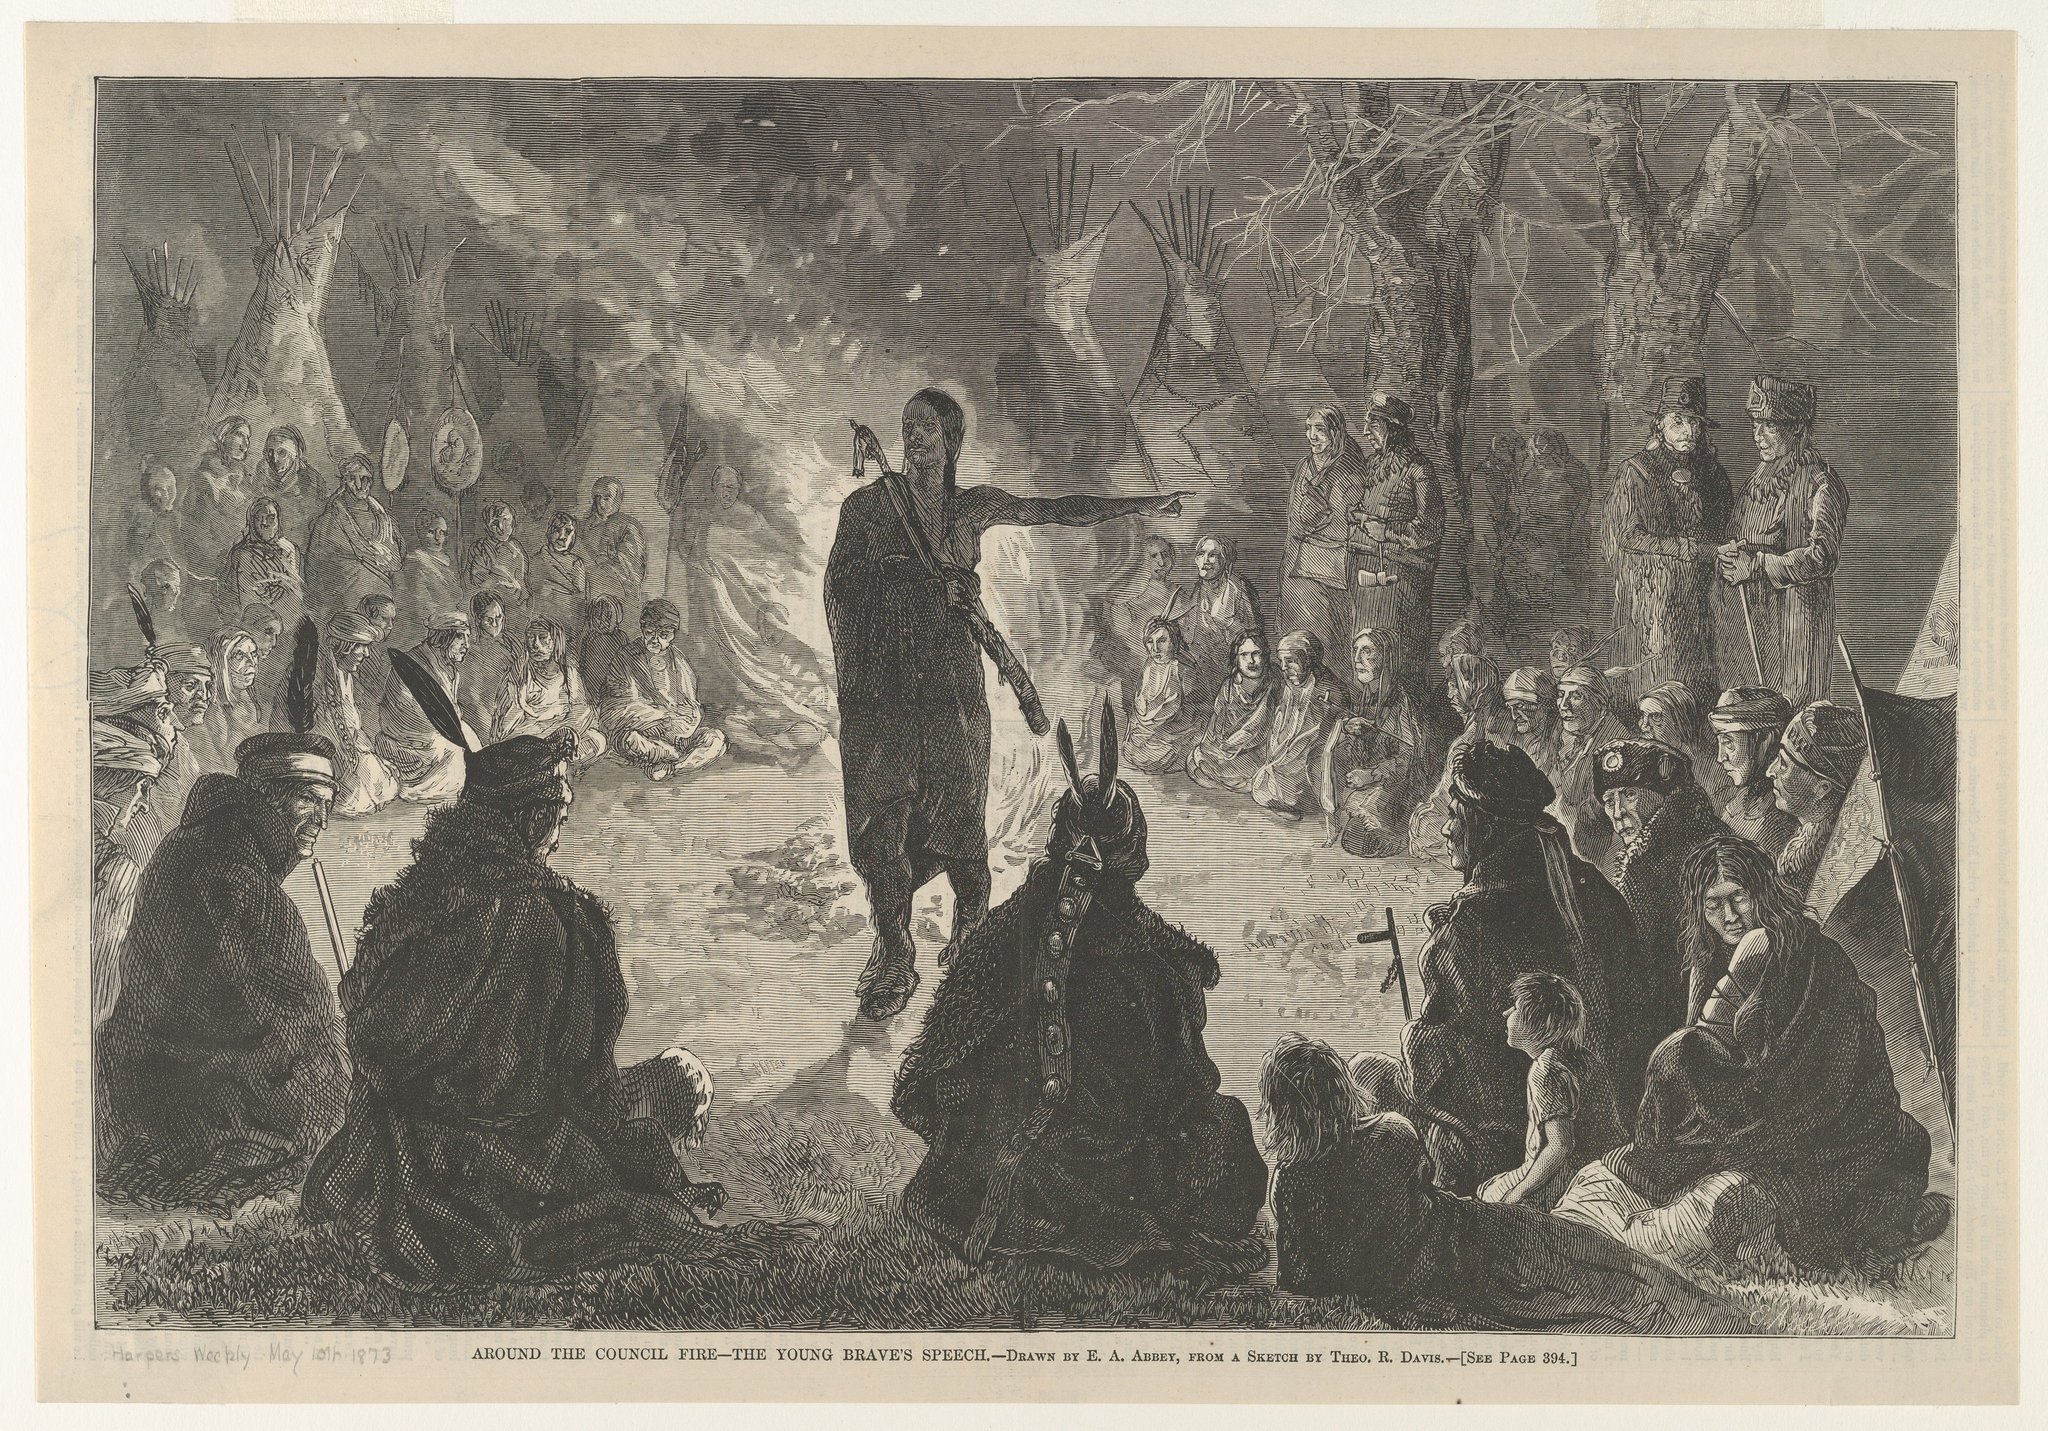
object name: print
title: Around the Council Fire, The Young Brave's Speech, from "Harper's Weekly"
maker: edwin austin abbey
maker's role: artist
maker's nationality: american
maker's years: 1852-1911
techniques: engraving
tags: children,men,women,fire